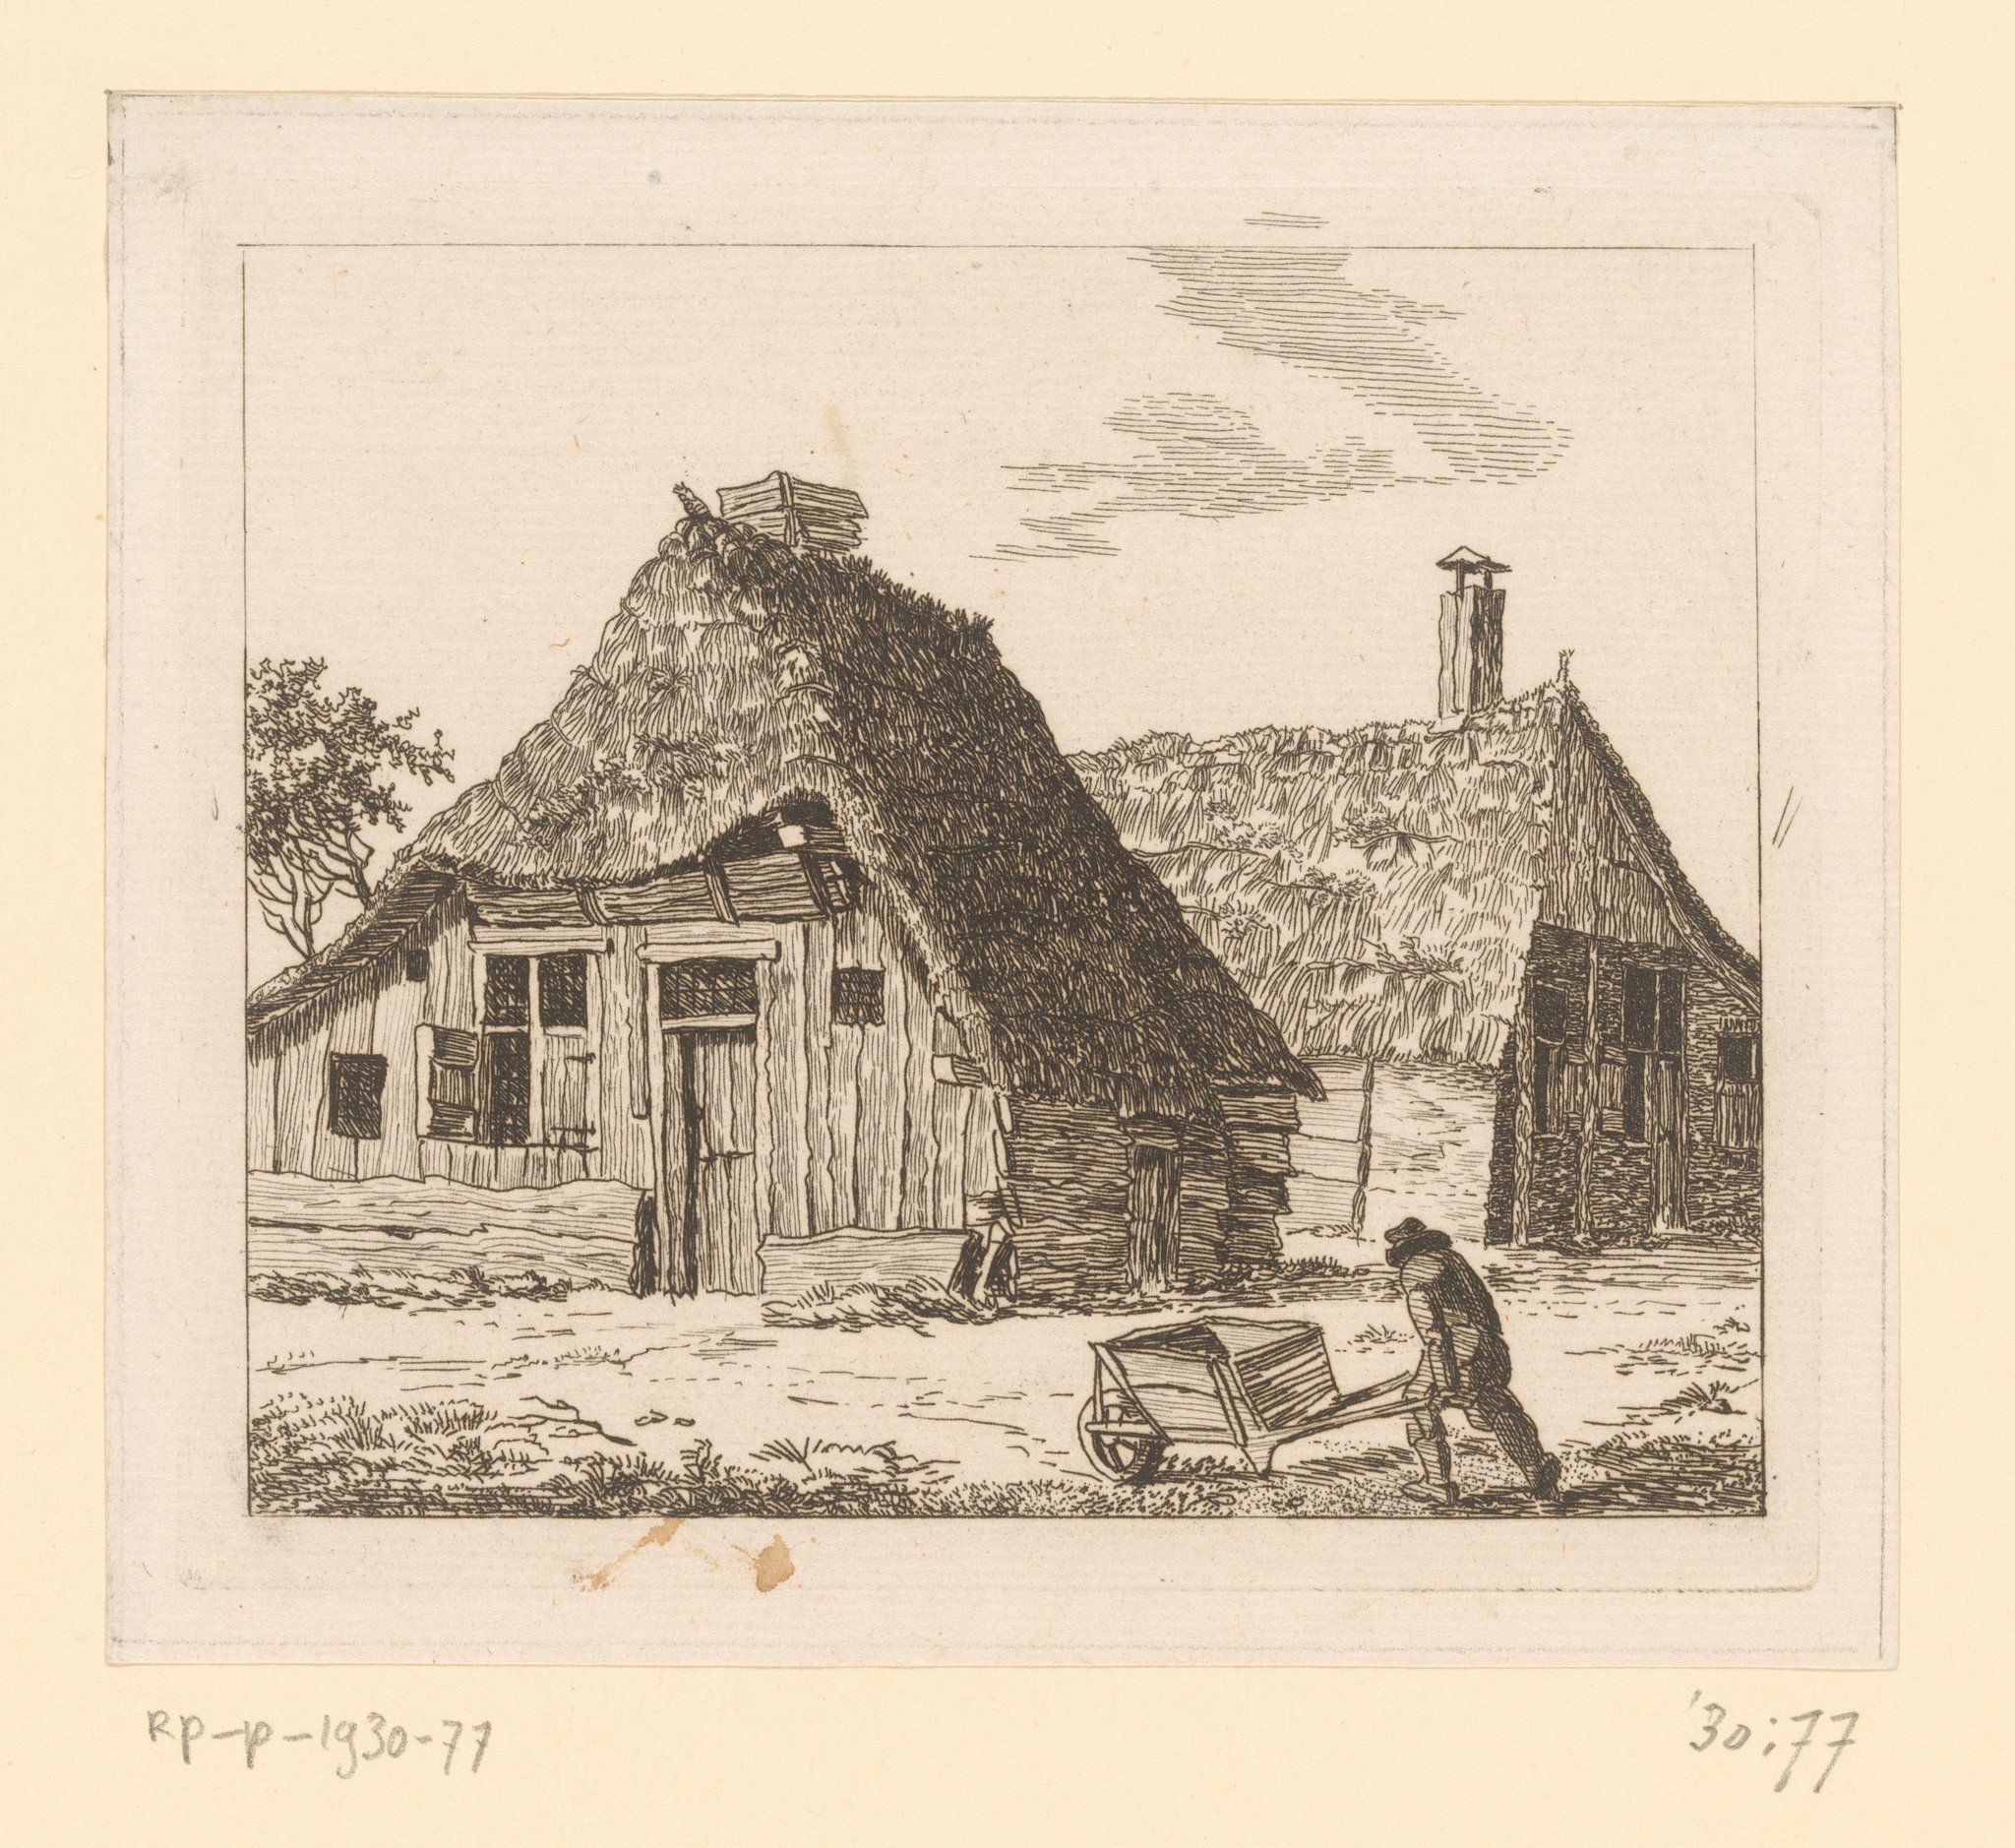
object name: print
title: Boerderijen te Rouveen bij Staphorst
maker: anthonie van den bos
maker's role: draughtsman, print maker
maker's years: 1763-1838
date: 1773-1838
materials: paper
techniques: etching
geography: netherlands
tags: farm (building)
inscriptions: collector's mark: Lugt 2233